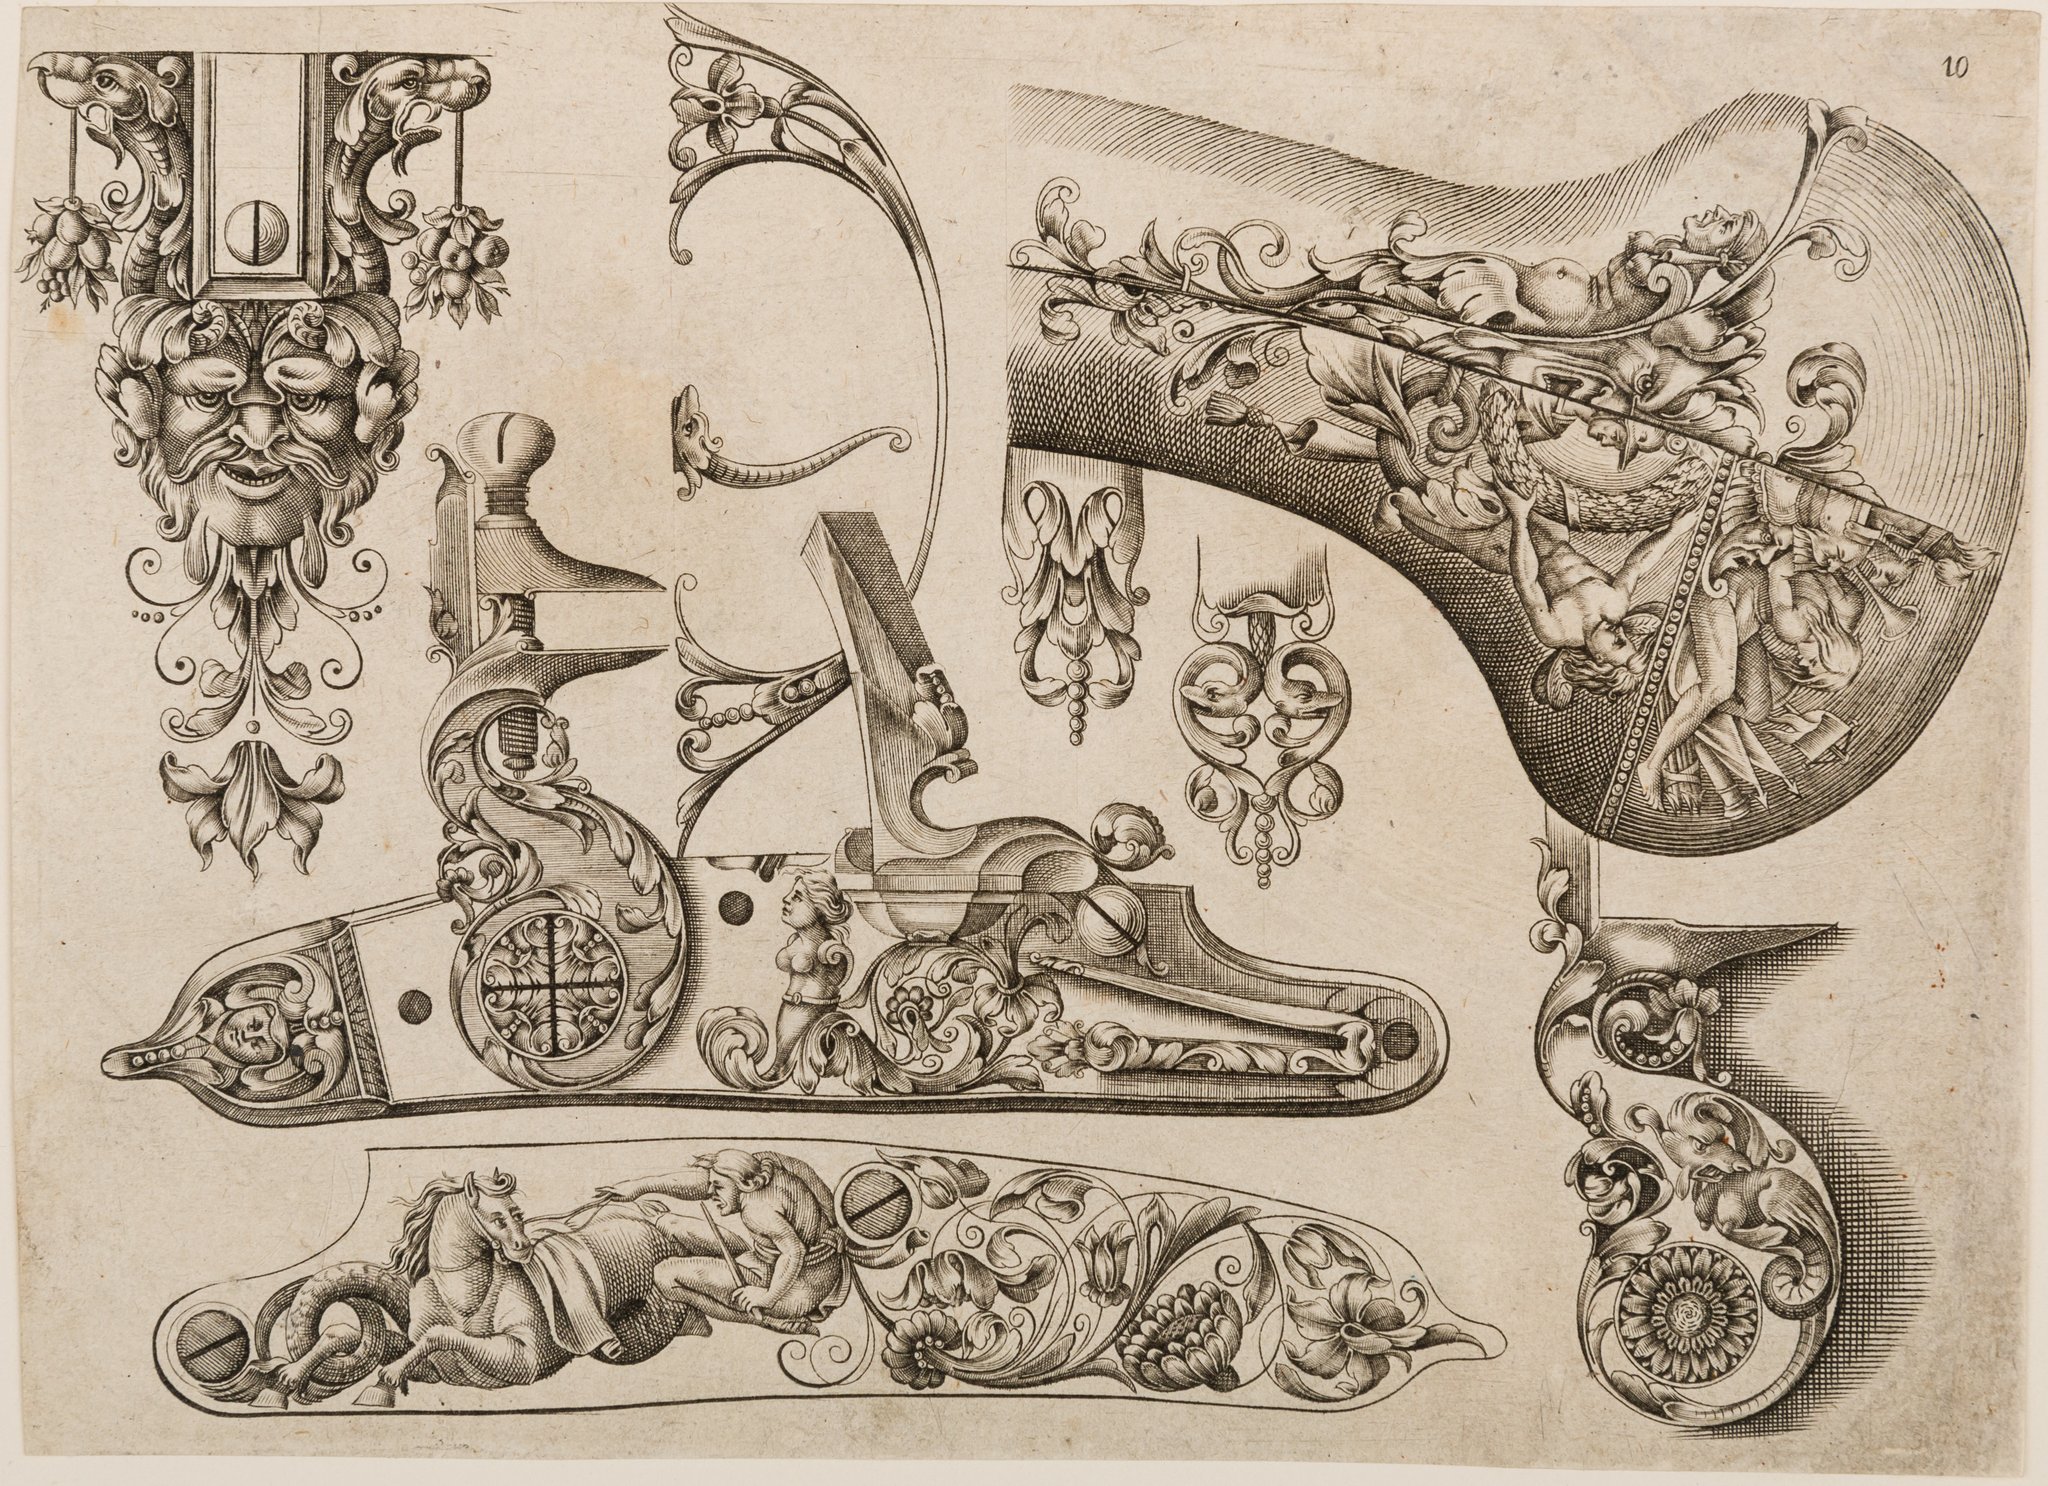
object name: engraving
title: Plate Ten from Plusieurs Models des plus nouuelles manieres qui sont en usage en l'Art de Arquebuzerie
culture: french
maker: c. jacquinet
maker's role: engraver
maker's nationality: french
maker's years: 1625-1675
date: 1660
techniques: engraving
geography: france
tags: ornament